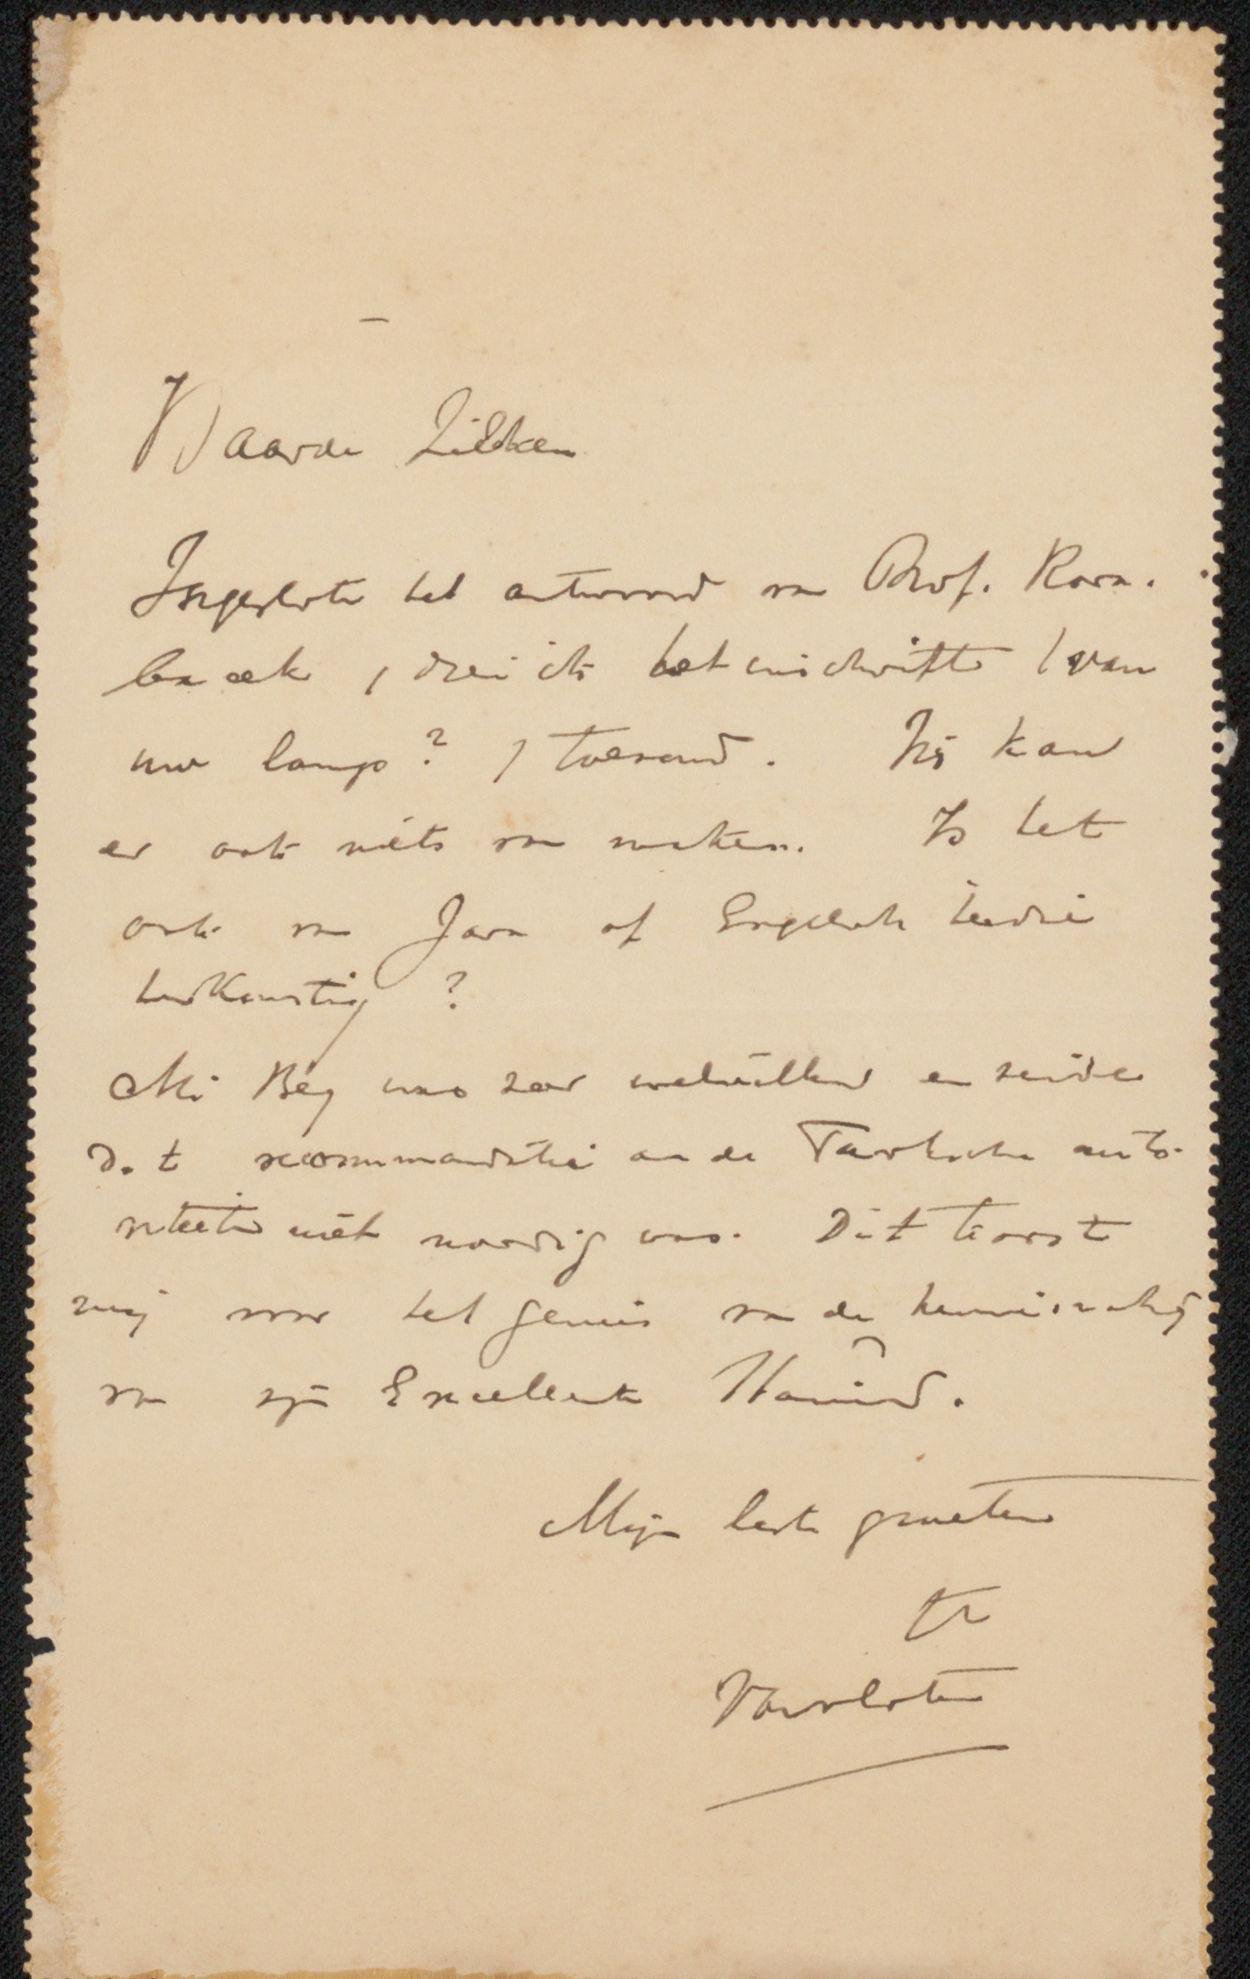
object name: letter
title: Brief aan Philip Zilcken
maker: gerlof van vloten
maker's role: redacteur, schrijver, vertaler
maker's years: 1866-1903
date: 1876-1903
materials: ink, paper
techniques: pen, writing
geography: leiden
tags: the hague, painter, draughtsman, philip zilcken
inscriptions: collector's mark: ‘RPK’